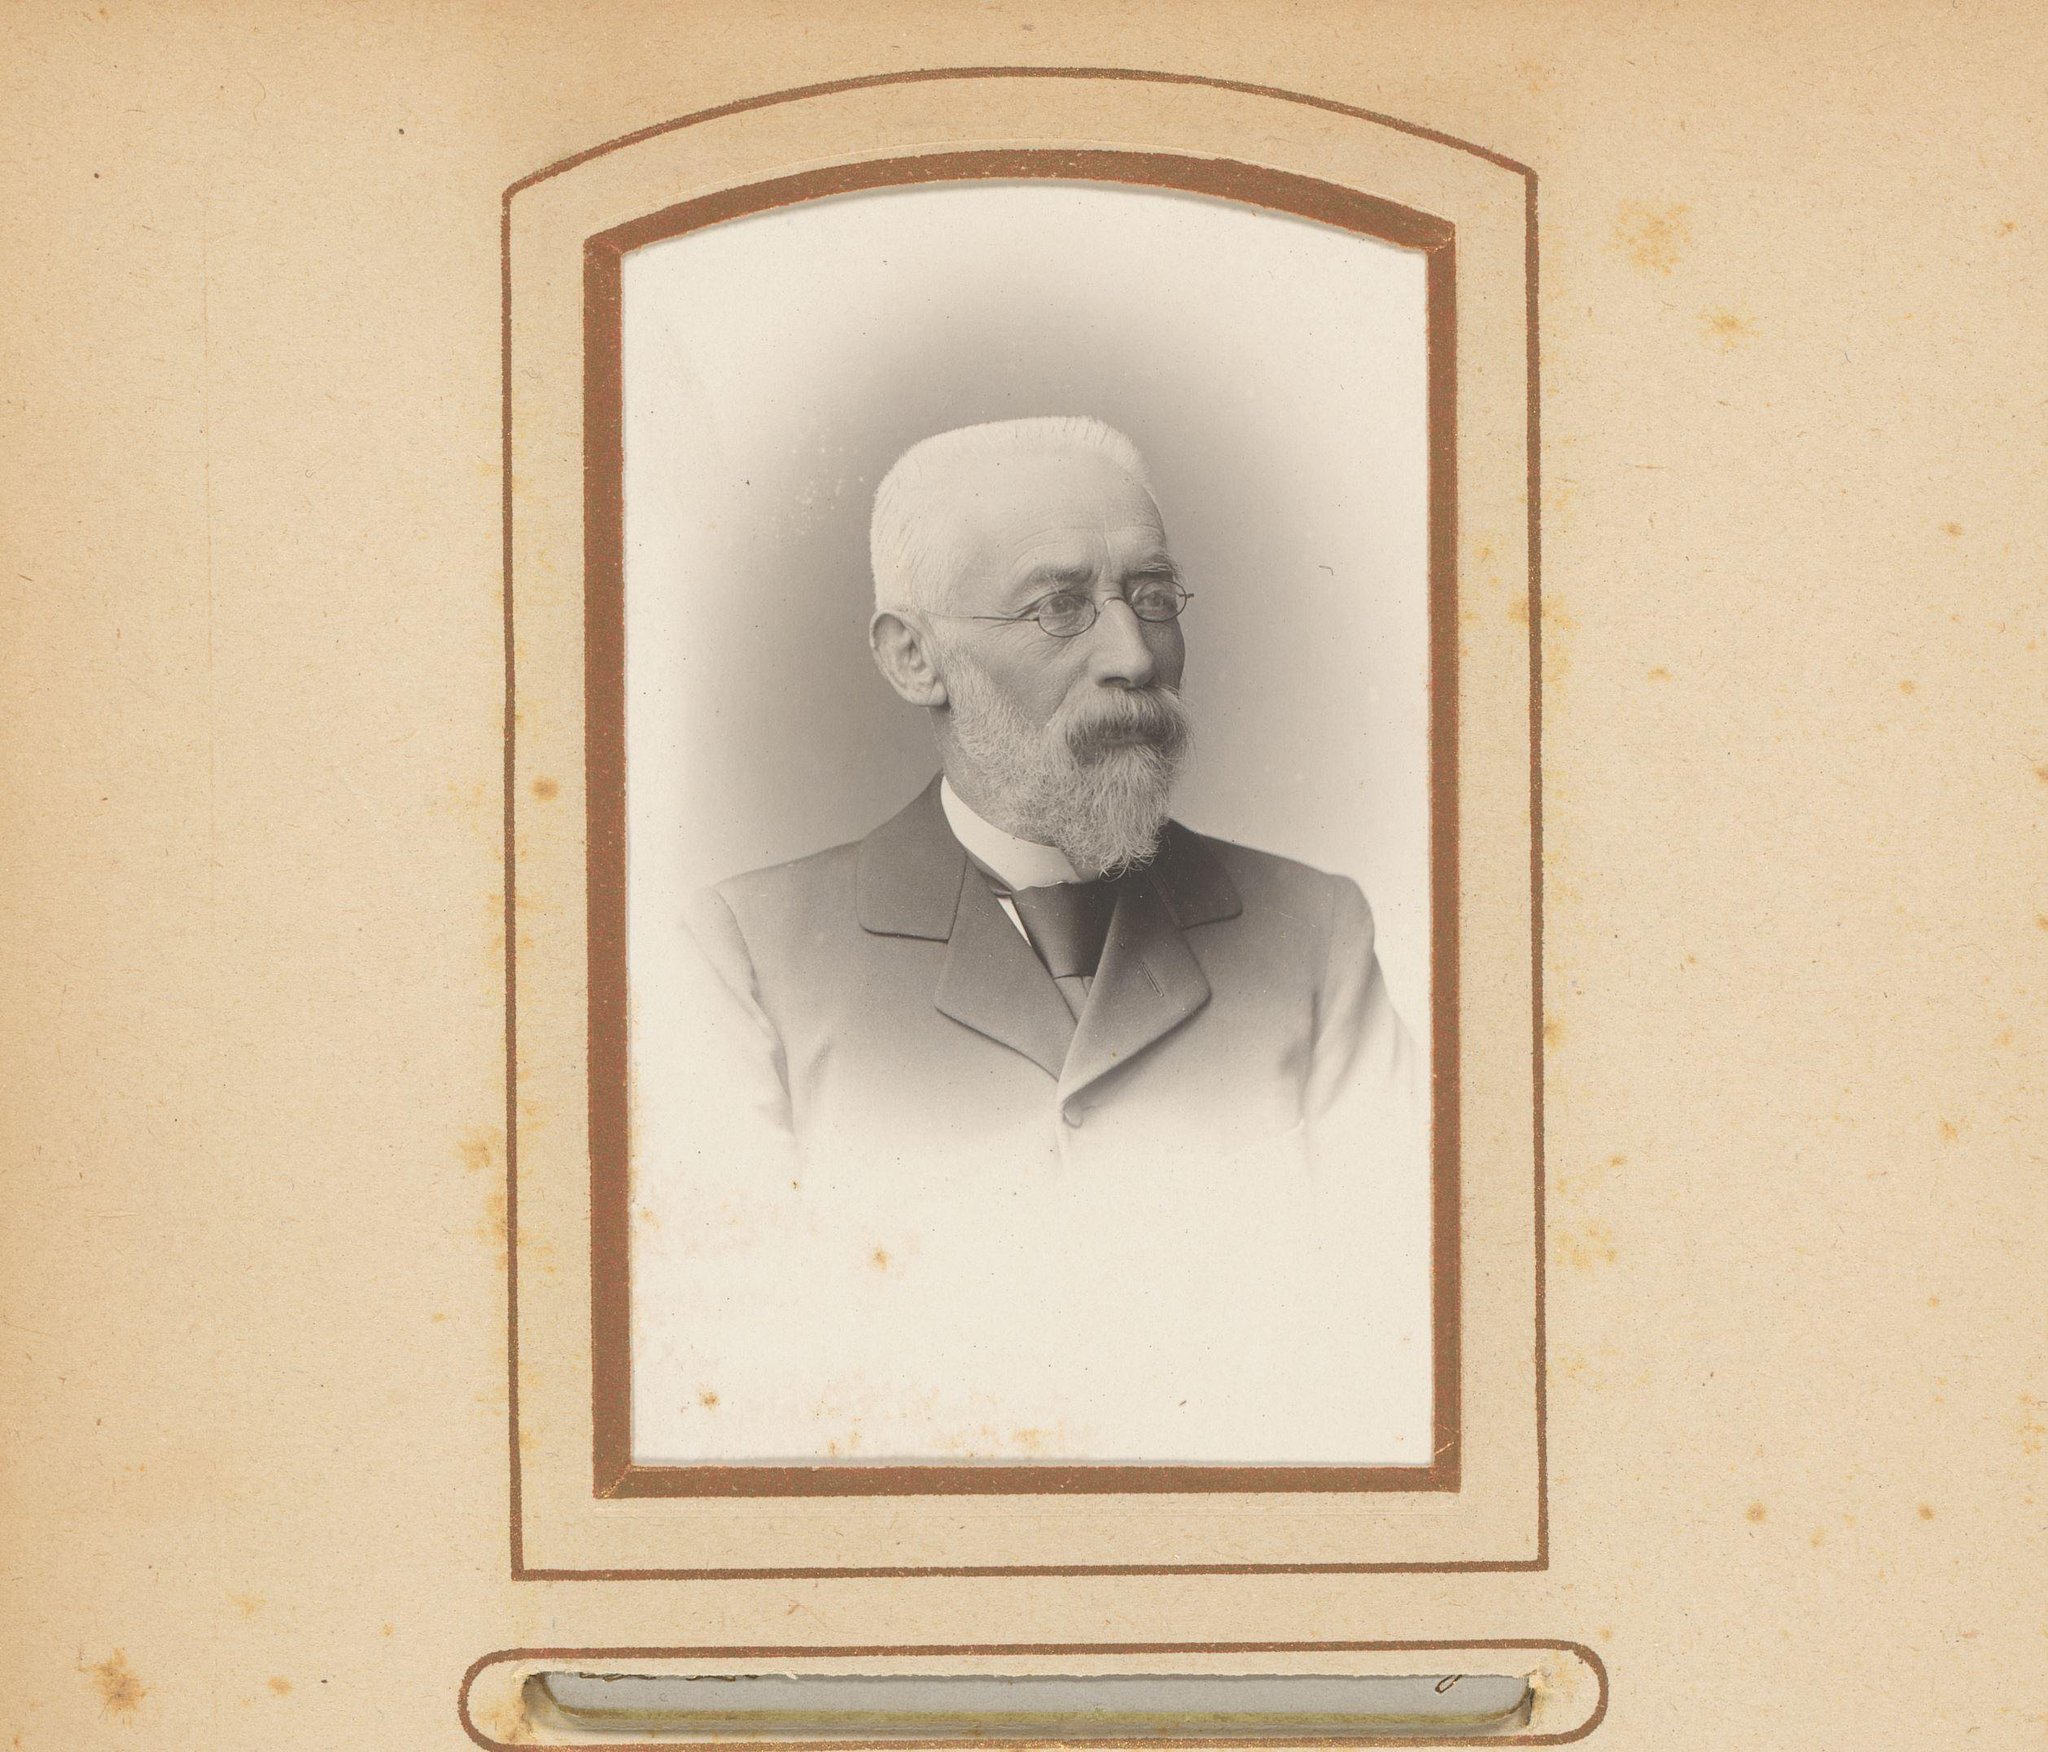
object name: photograph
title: Portret van een man met baard en bril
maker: carl wilhelm bauer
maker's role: fotograaf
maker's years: 1844-1911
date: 1880-1908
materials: cardboard, photographic support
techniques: collodion silver print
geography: middelburg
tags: eyeglasses, spectacles, historical persons, beard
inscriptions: inscription: ‘C.W. Bauer/ Middelburg’